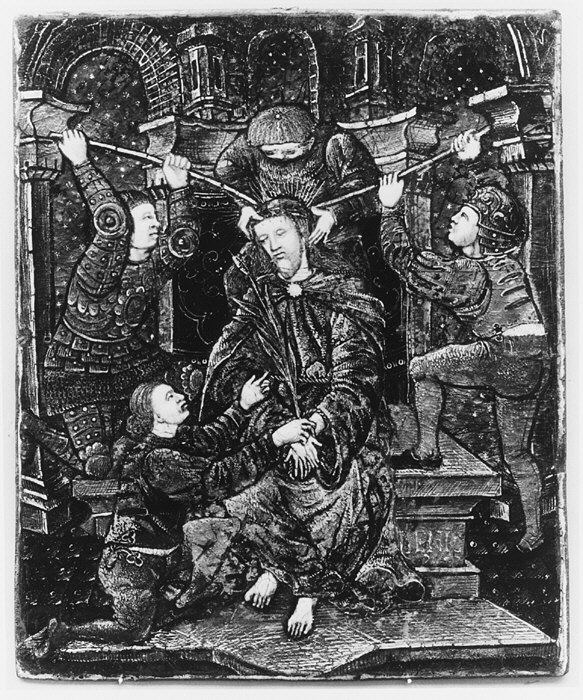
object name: plaque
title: Christ Crowned with Thorns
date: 1801-1900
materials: copper, enamel, gilt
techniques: painting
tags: men,christ